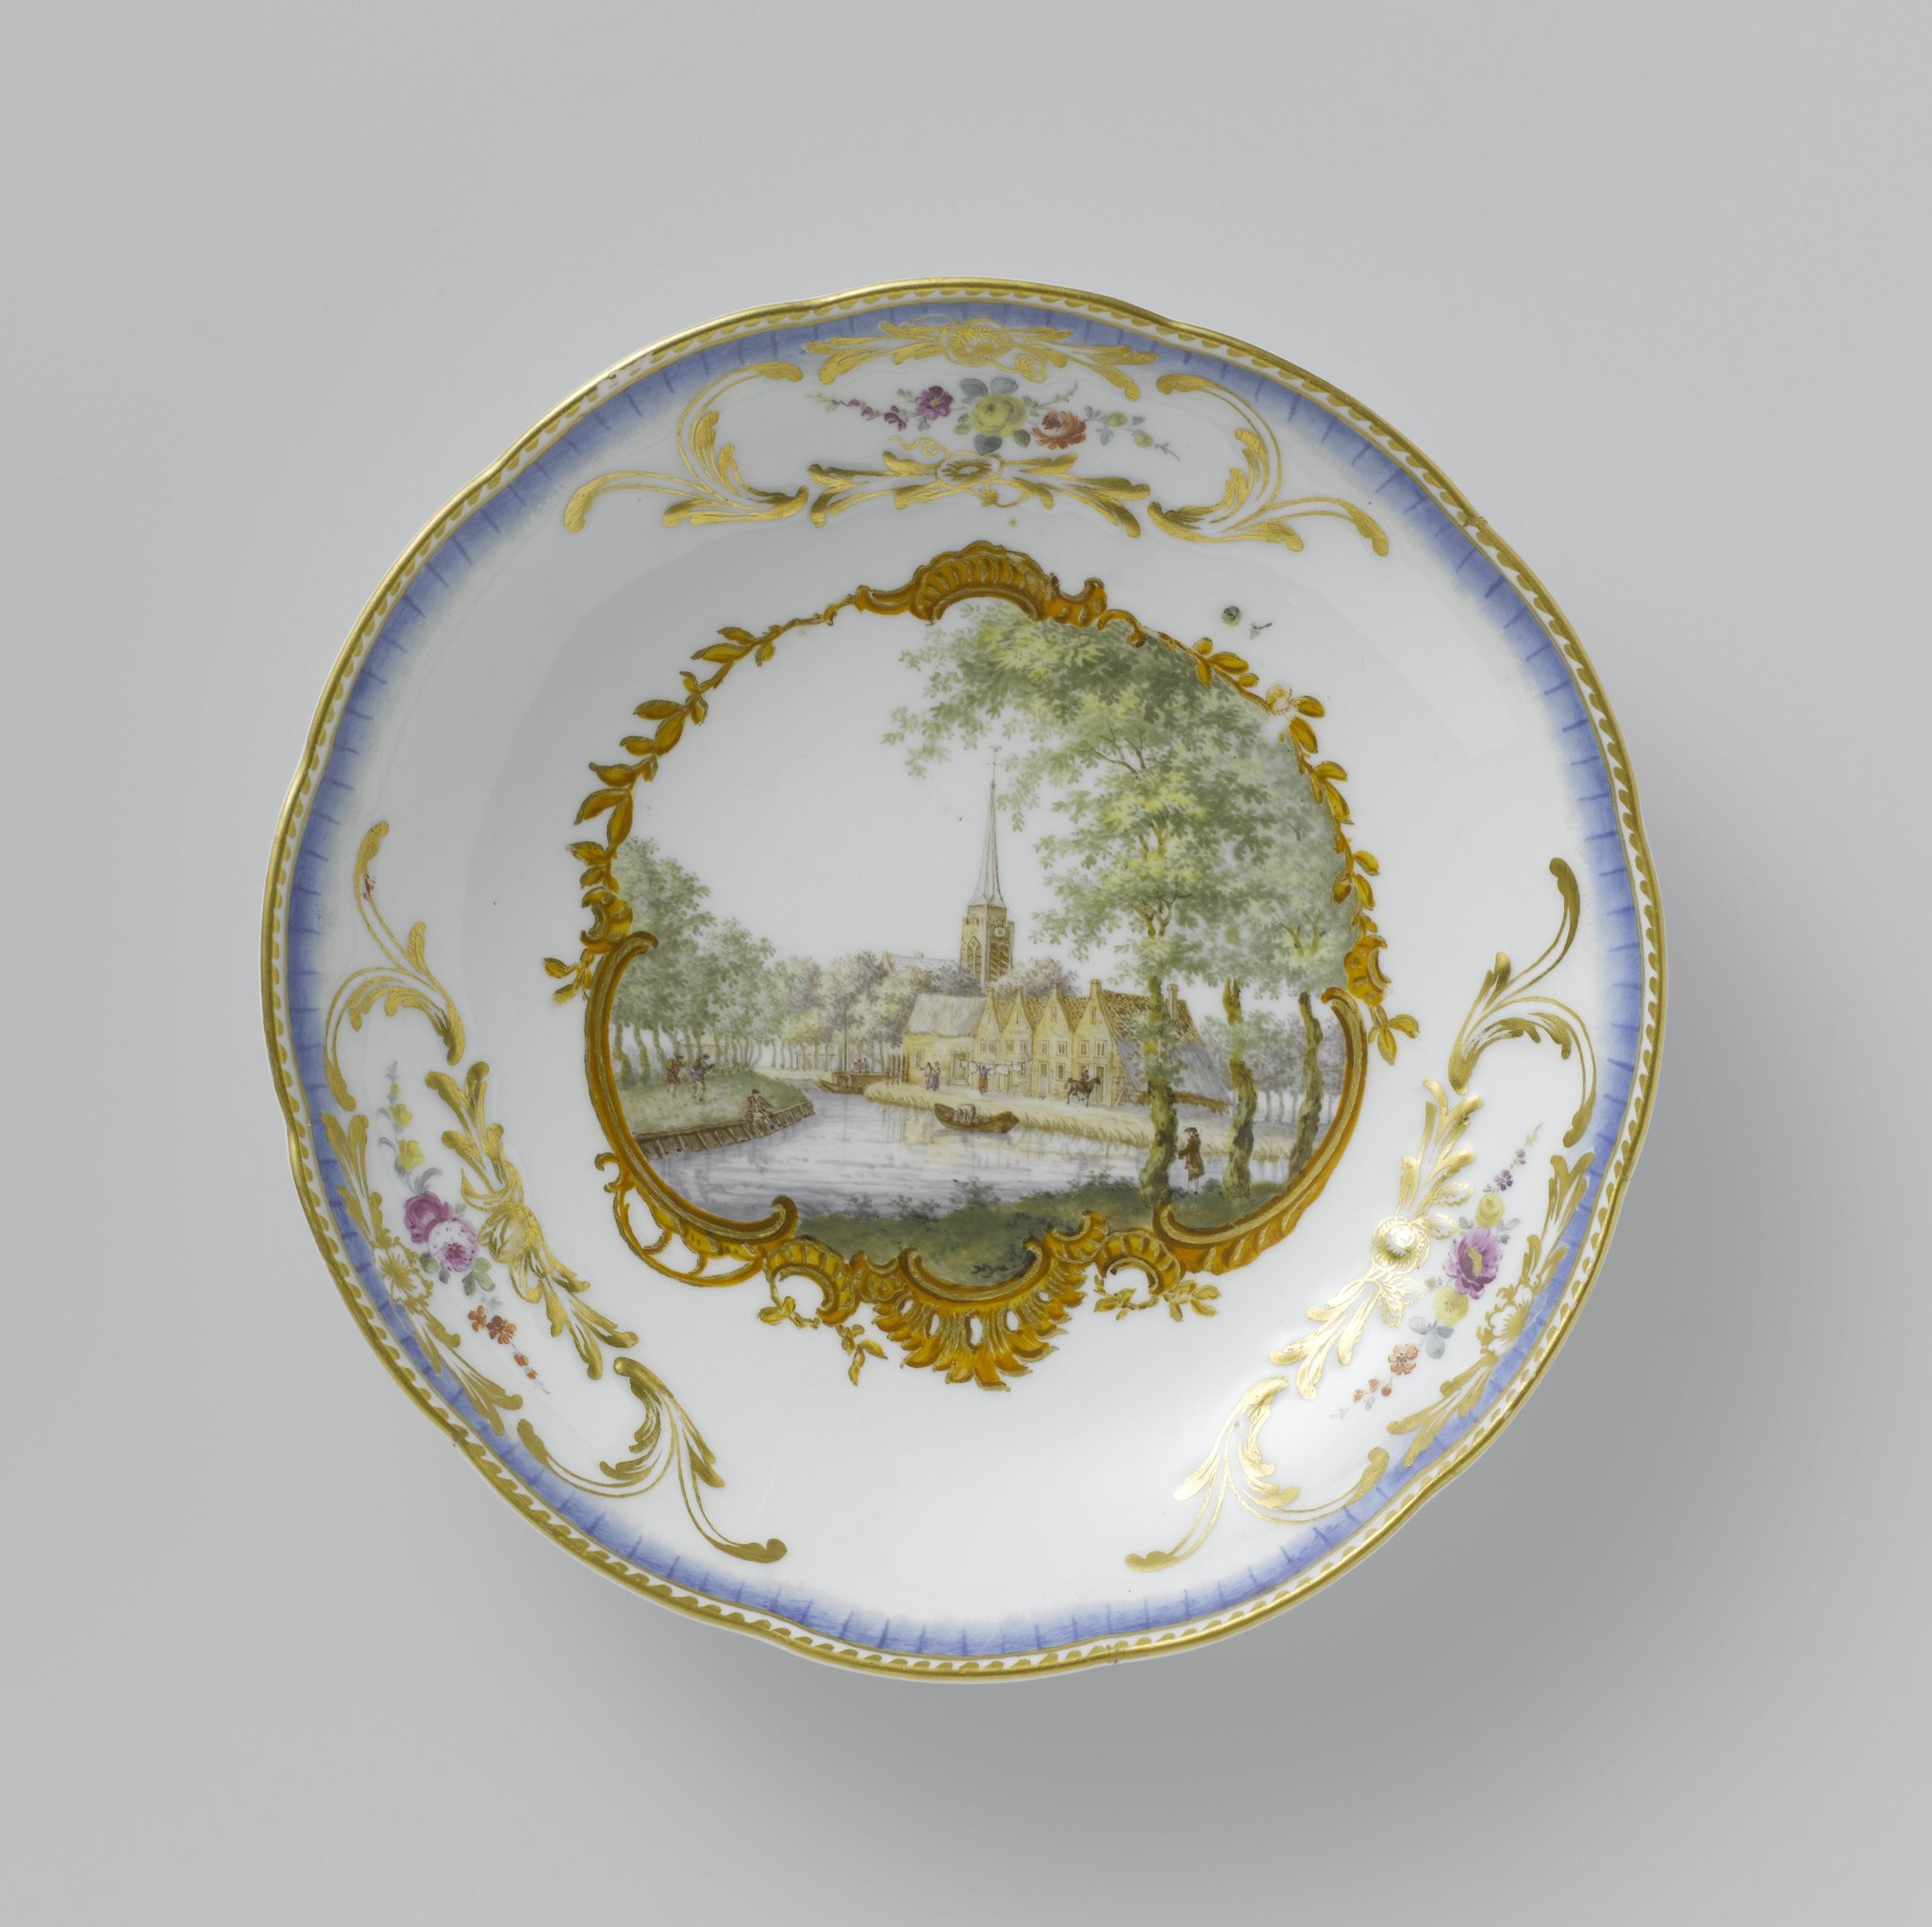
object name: eating drinking utensil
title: Seven plates from the service of Stadtholder William v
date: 1772-1774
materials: porcelain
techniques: painted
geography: meissen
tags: the hague, william v (prince of orange)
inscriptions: mold mark: ‘L’, factory mark, inscription: ‘Abcoude aan de Vegt’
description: These seven plates are from a 435-part service owned by Stadtholder William v of Orange. The service was produced in Meissen between 1772 and 1774, possibly on commission for the Dutch East India Company (VOC). The plates bear scenes of various Dutch cities and buildings, as well as views of Java and Ceylon, then important Company territories.